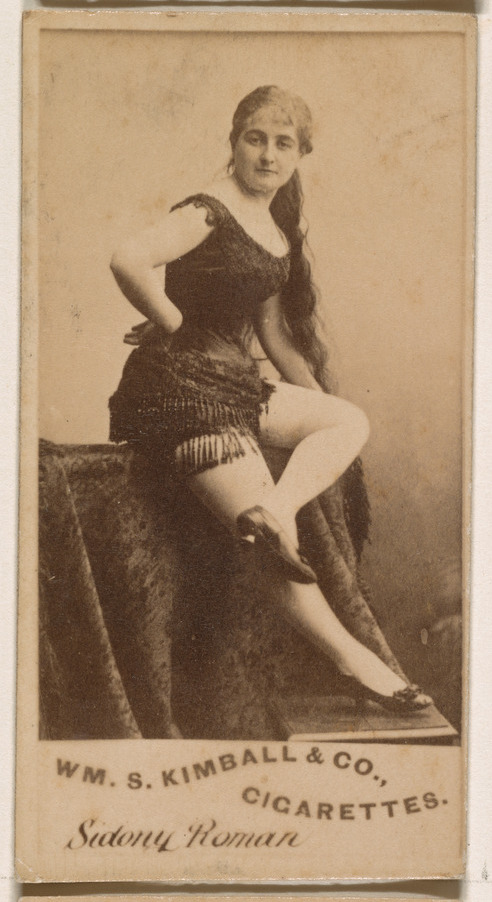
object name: photograph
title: Sidony Roman, from the Actresses series (N203) issued by Wm. S. Kimball & Co.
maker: william s. kimball & company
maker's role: publisher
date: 1889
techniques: color lithograph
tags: portraits,women,actresses